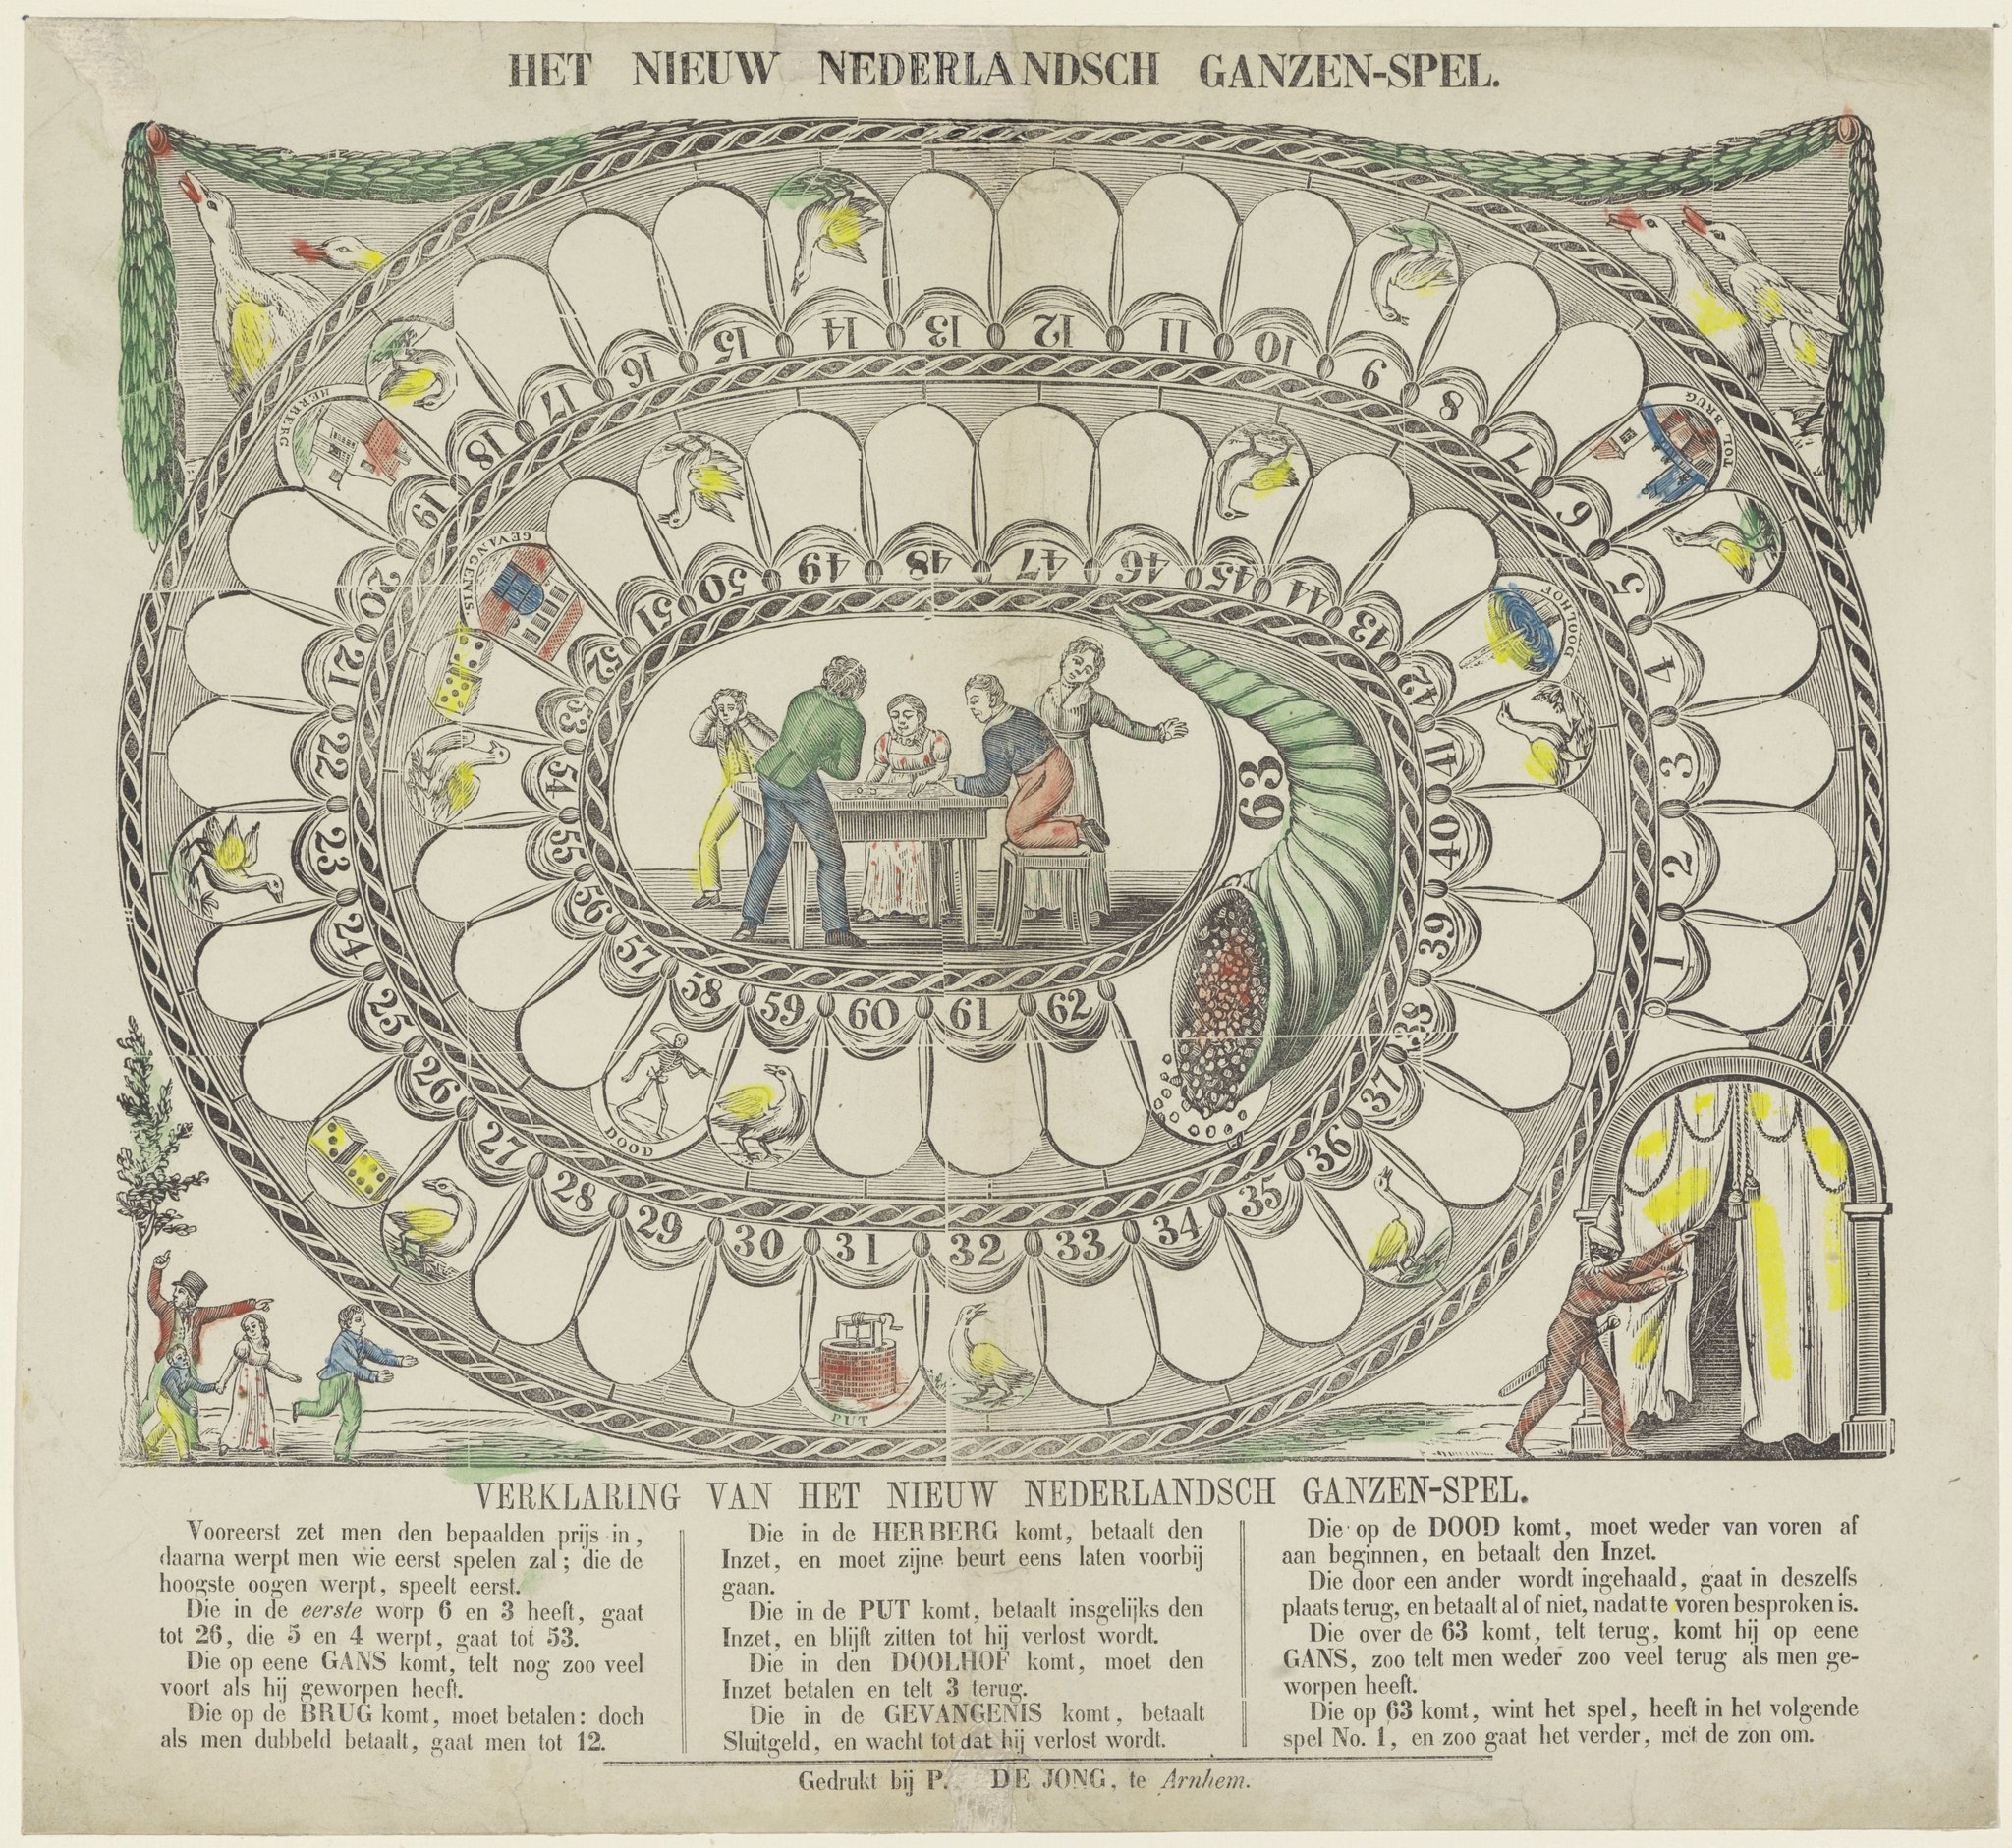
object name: popular print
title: Het nieuw Nederlandsch Ganzen-spel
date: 1842-1873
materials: paper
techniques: colour, letterpress printing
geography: arnhem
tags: goose-game, children's games and plays, board-games of chance, board-games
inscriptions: collector's mark: Lugt 2760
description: Ganzenbordspel met vakjes in een spiraal, genummerd van 1 tot en met 63. Op het middenveld een voorstelling van een groep kinderen staand rond een tafel die een spelletje ganzenbord speelt. In de hoeken kinderen, harlekijn en ganzen. In de ondermarge de spelregels in drie kolommen.